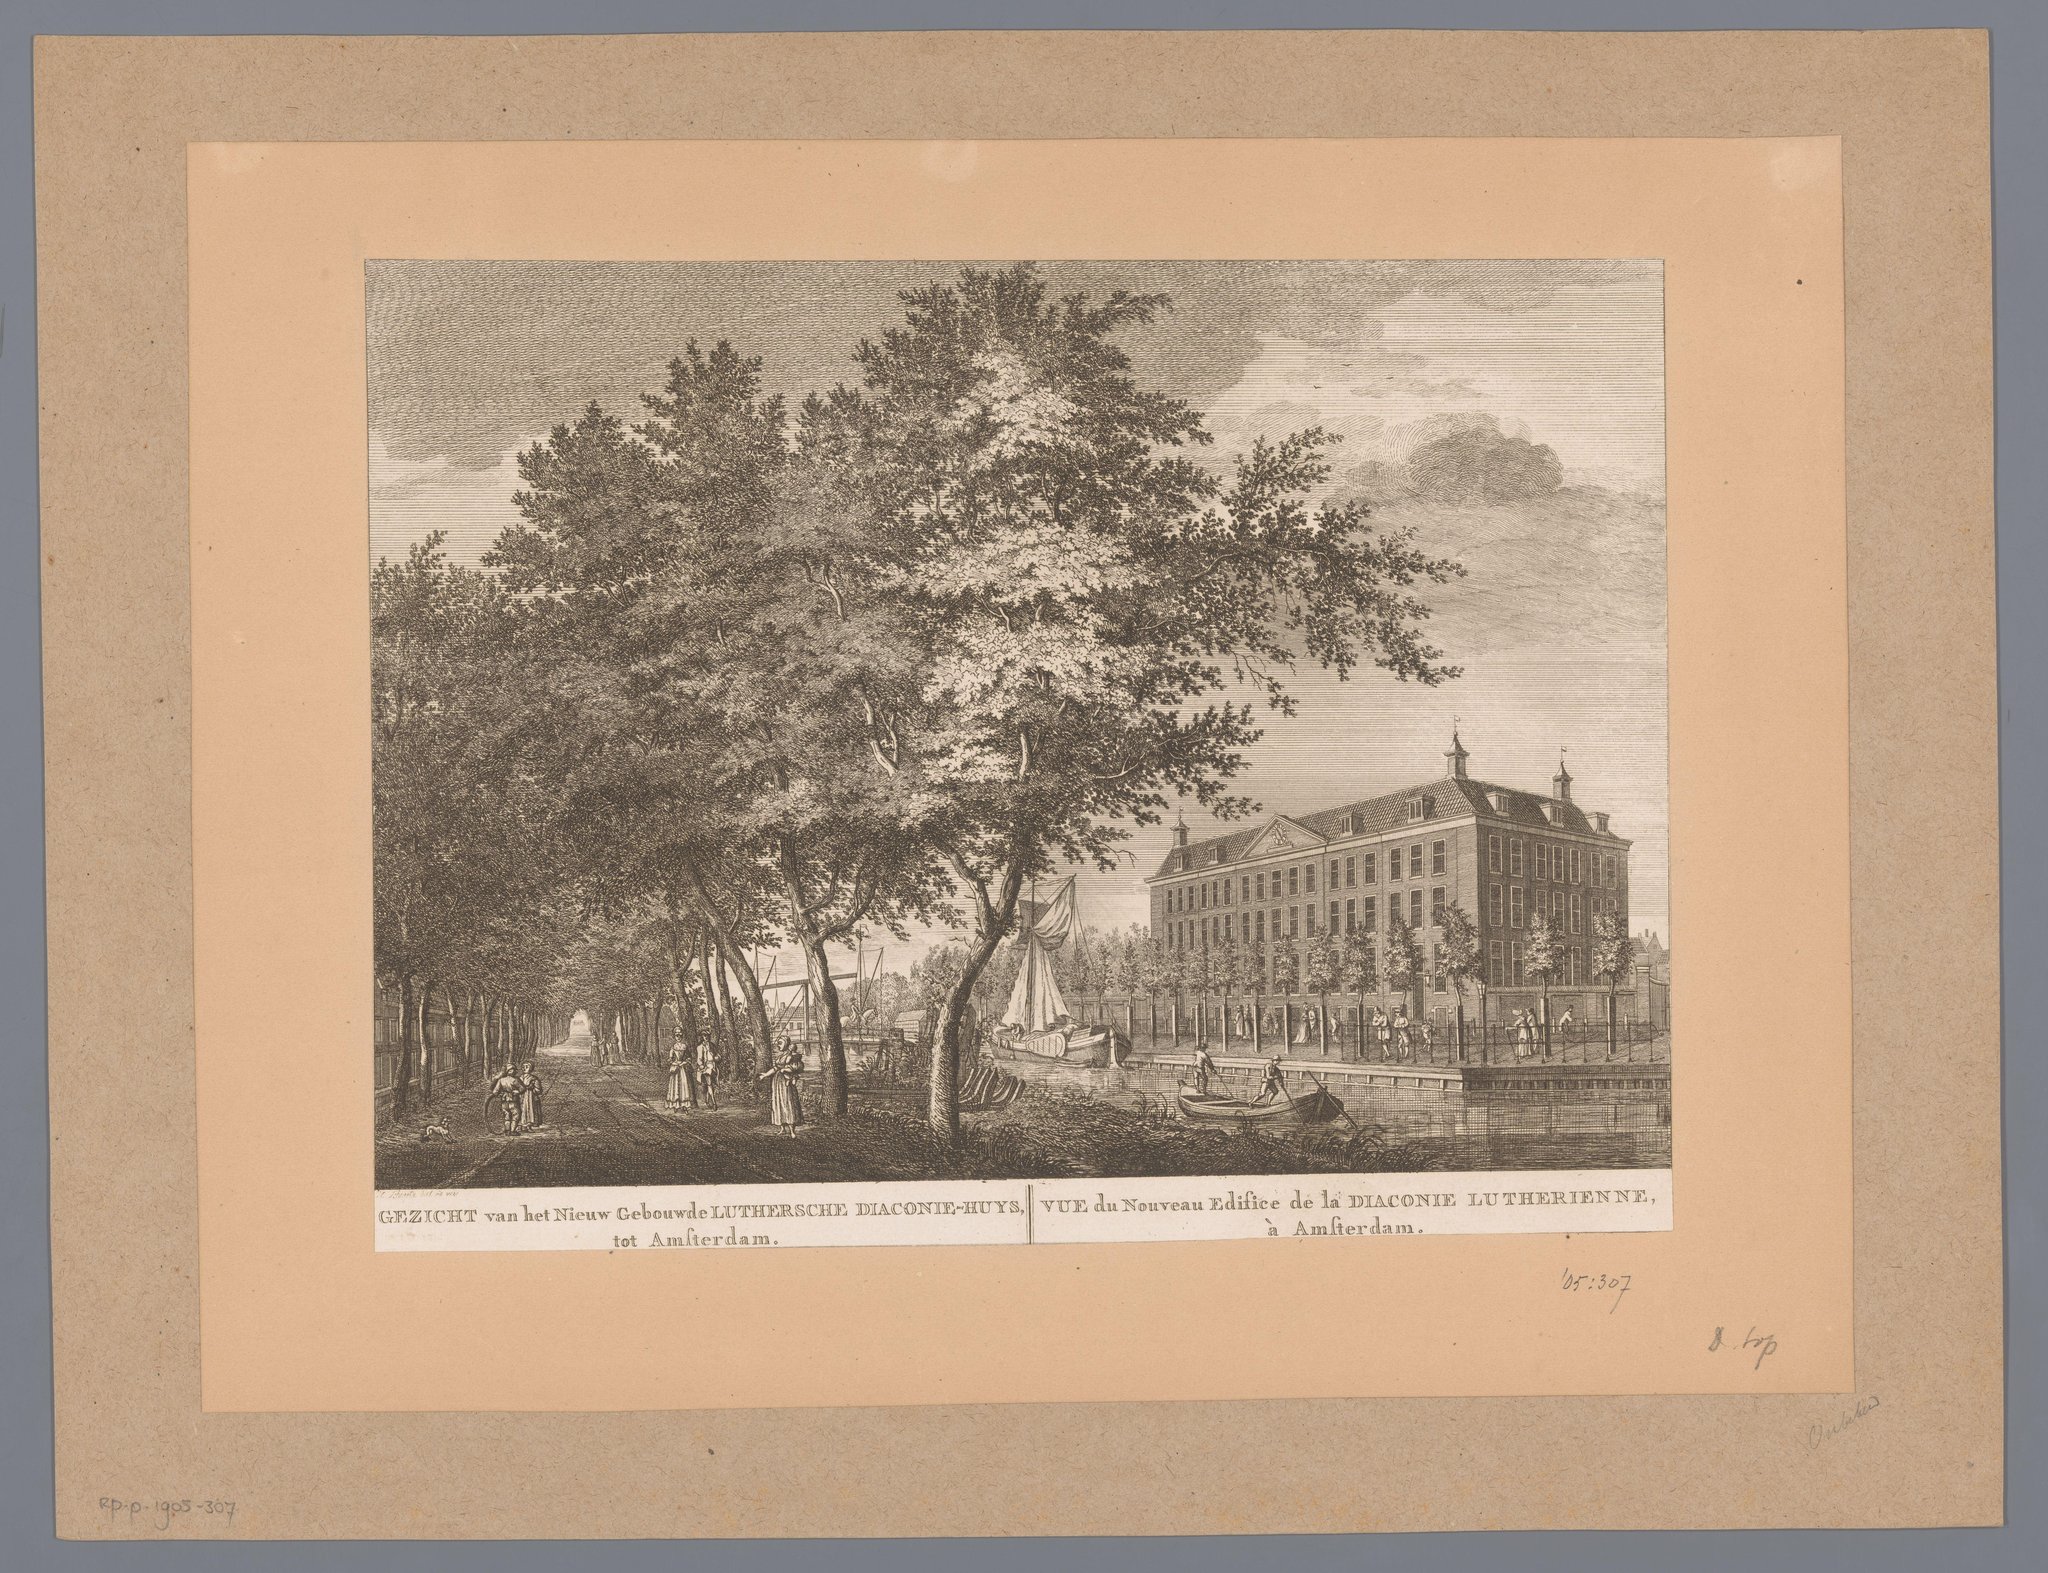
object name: print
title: Gezicht op het Lutherse Diaconiehuis te Amsterdam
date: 1753-1800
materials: paper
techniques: engraving, etching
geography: amsterdam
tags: (bowling a) hoop, poling, punting, bridge in city across river, canal, etc.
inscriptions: collector's mark: Lugt 2228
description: Deze prent lijkt sterk op die in de Atlas Fouquet. Deze is echter in spiegelbeeld, en verschilt in details. Mogelijk een eerdere, losse uitgave.